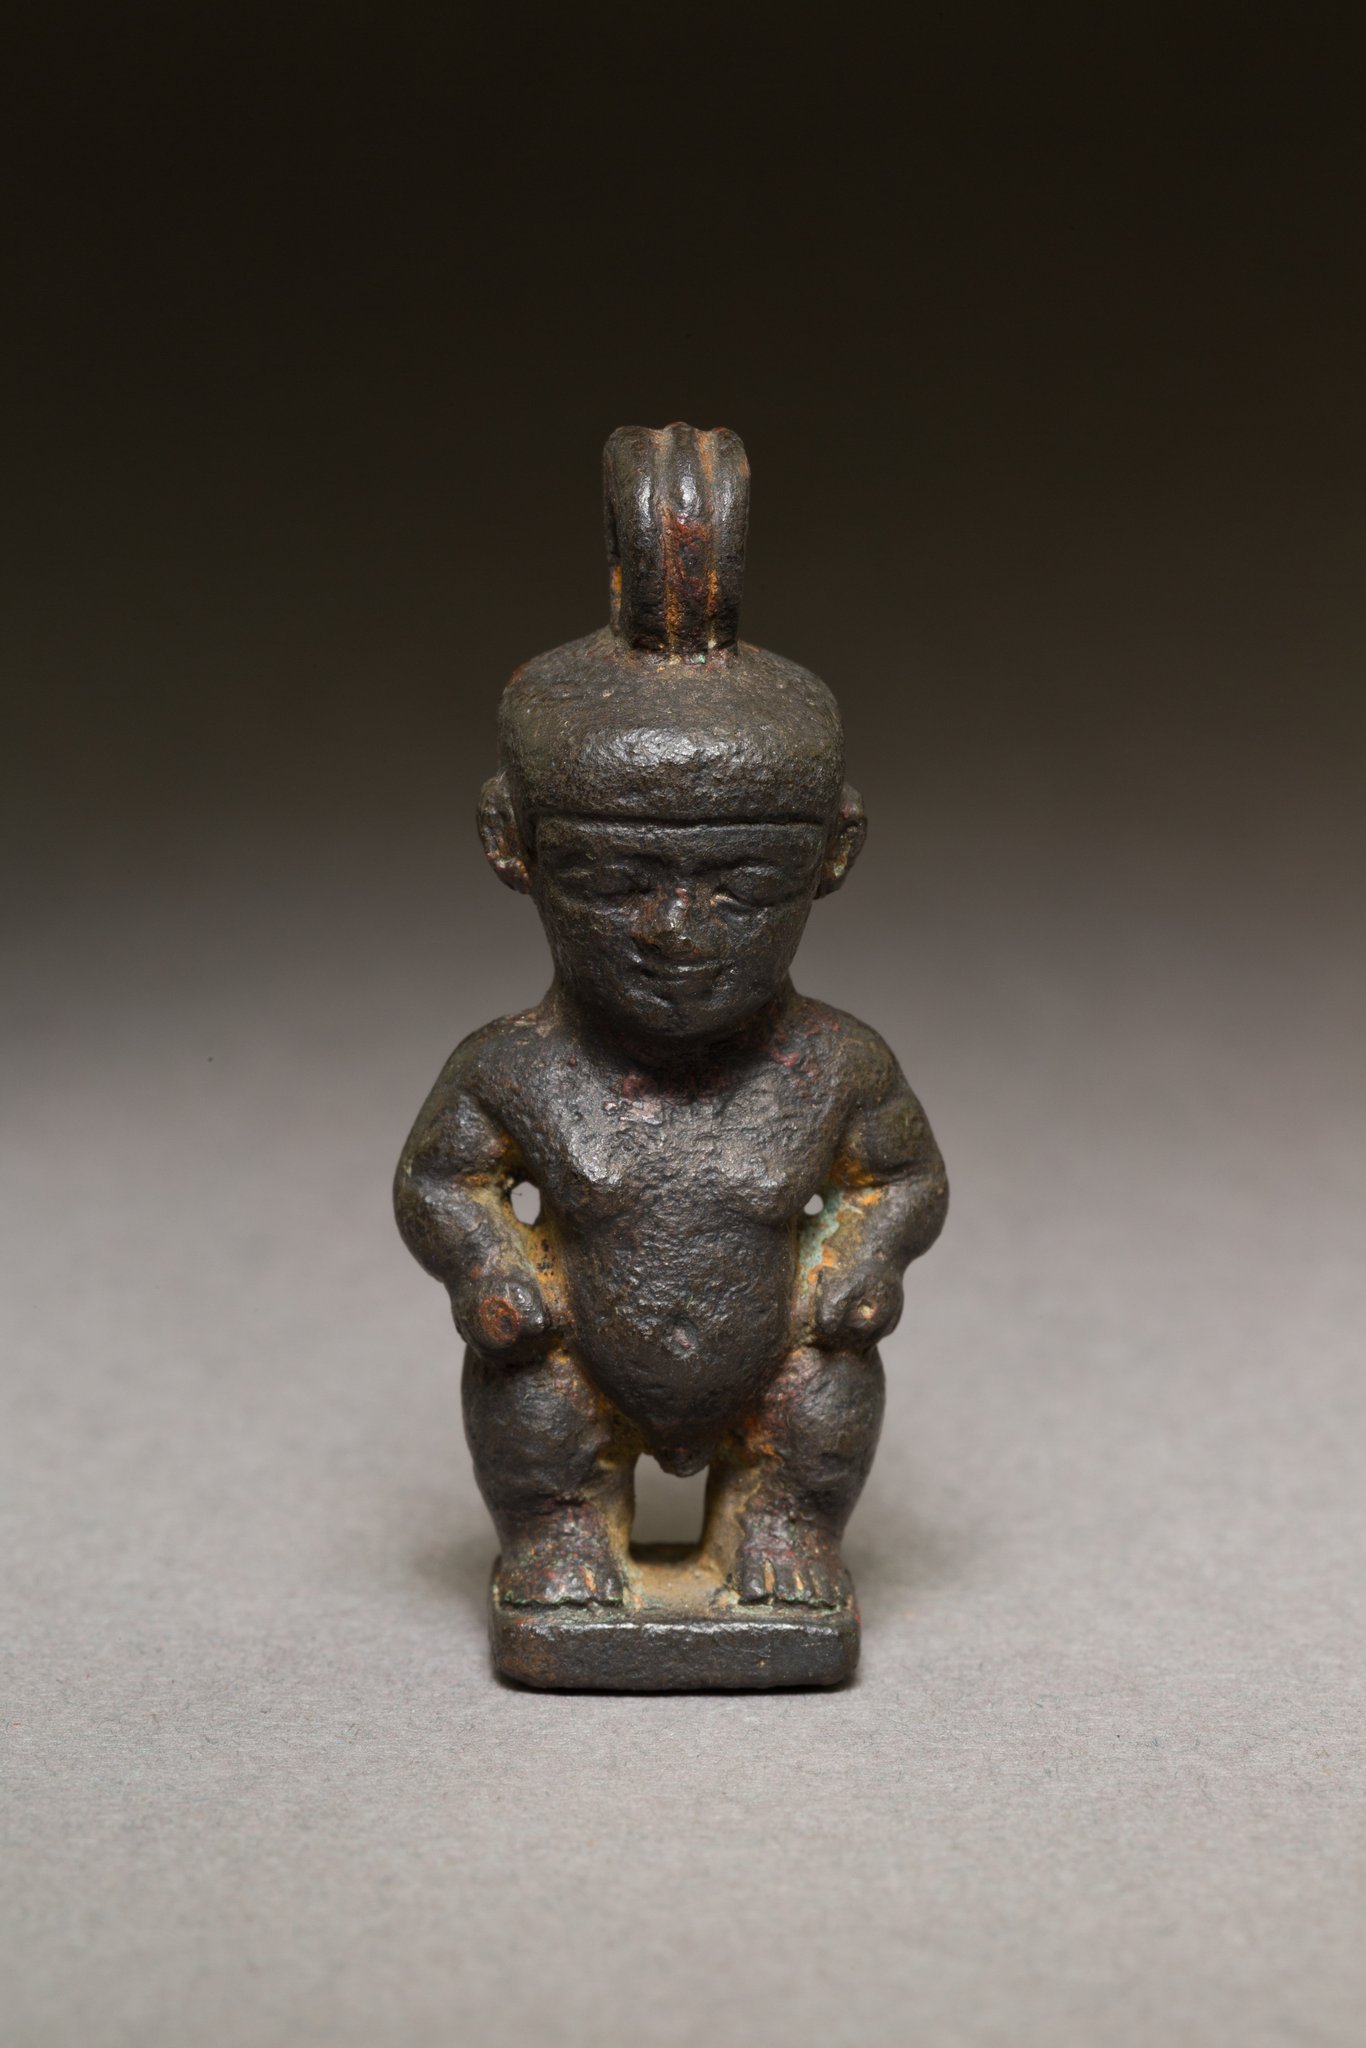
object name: amulet, pataikos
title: Pataikos with two faces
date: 664-630 BCE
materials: metal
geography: egypt